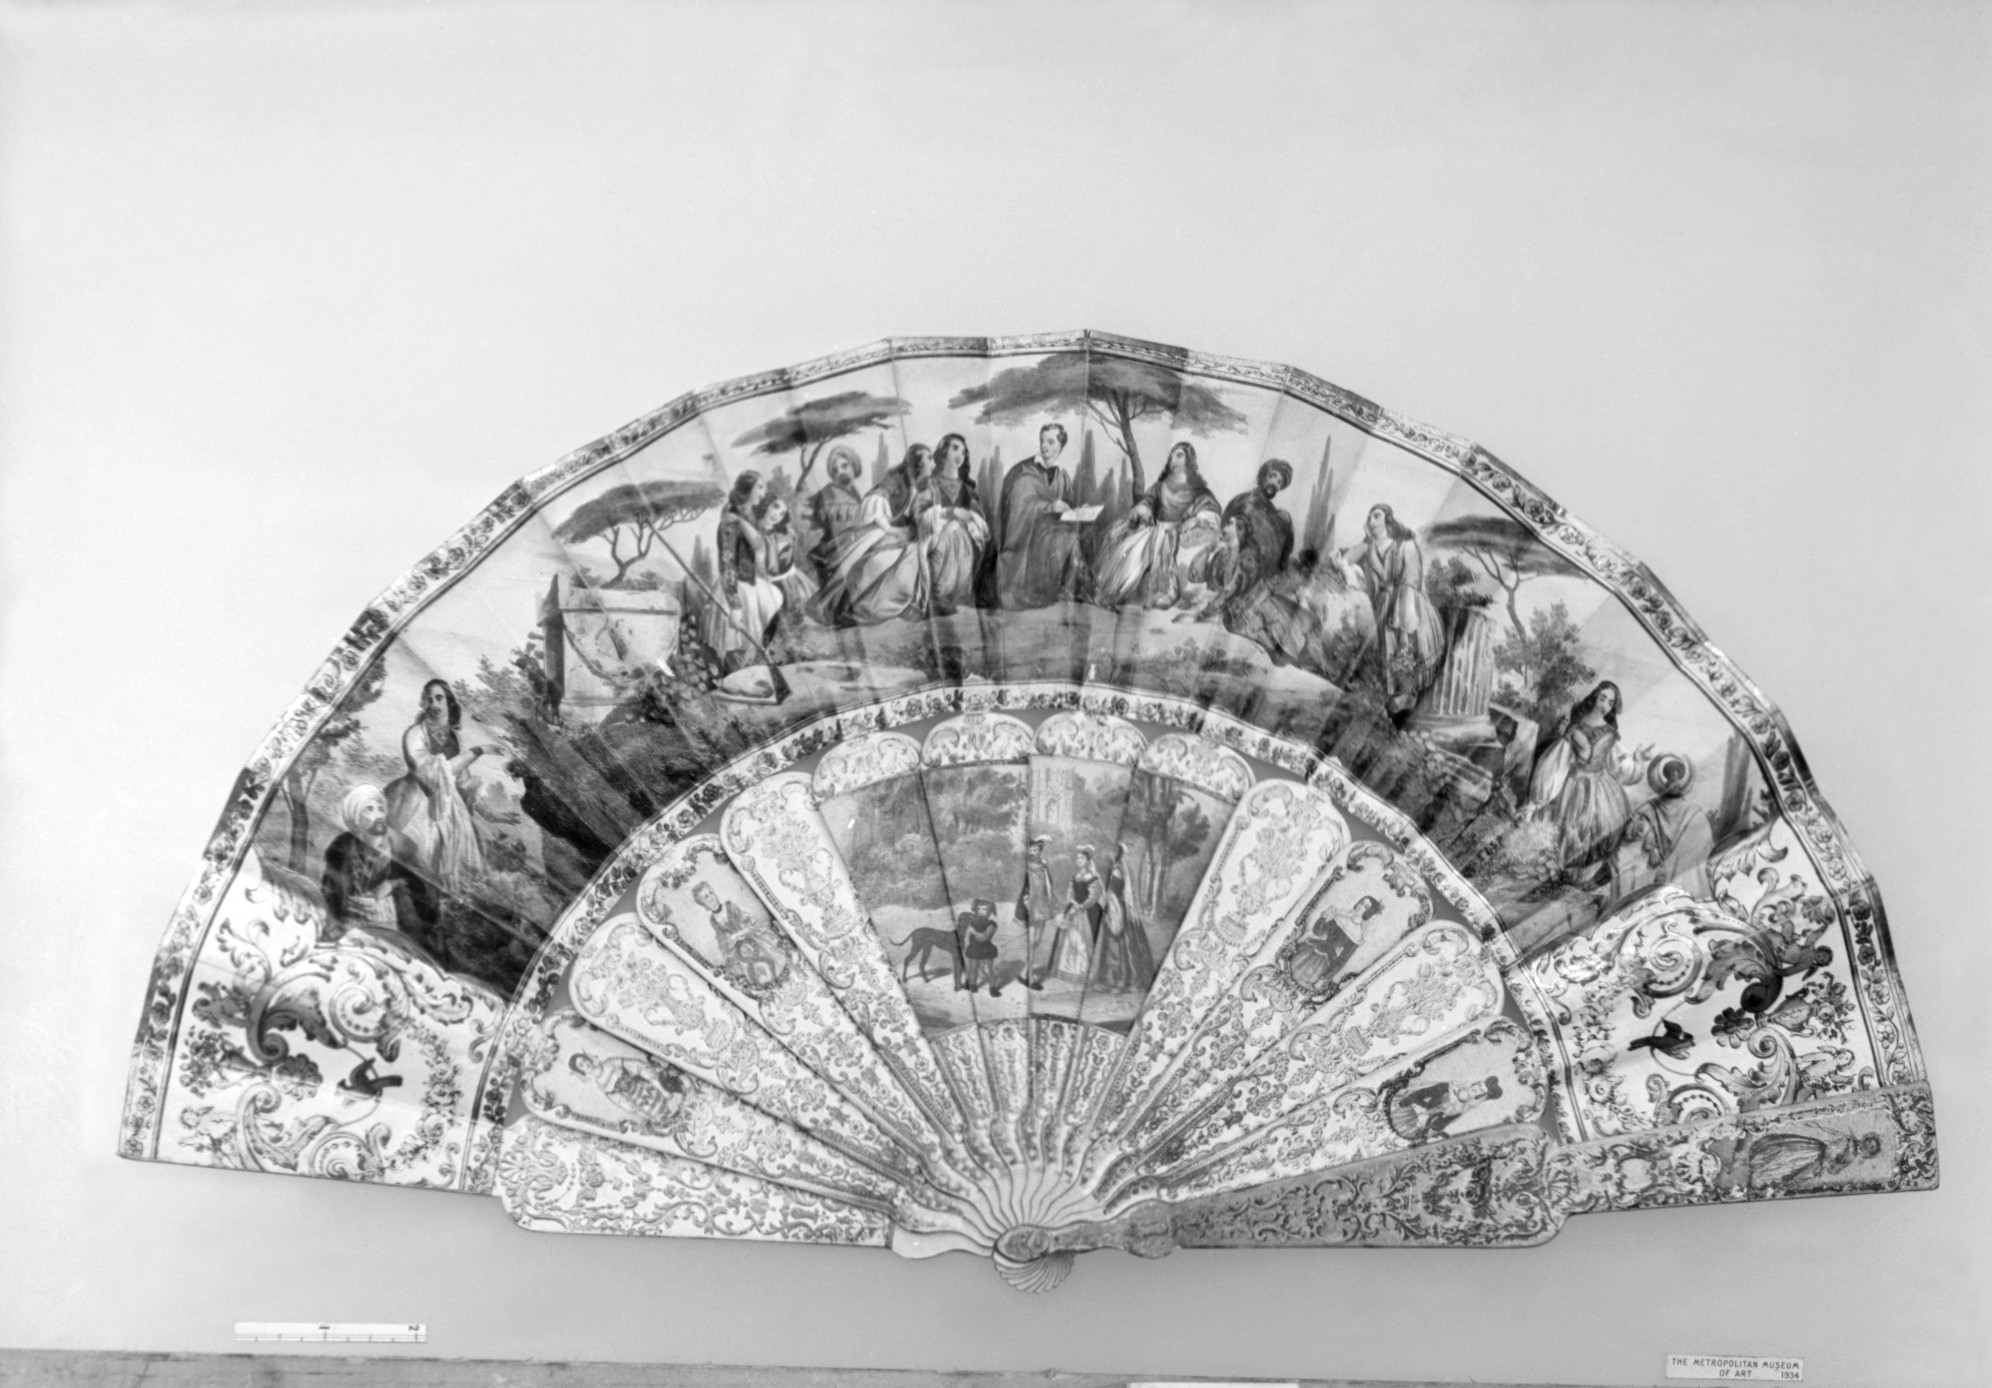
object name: fan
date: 1834-1866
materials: cardboard, paper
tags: birds,men,women,dogs,flowers,crowd